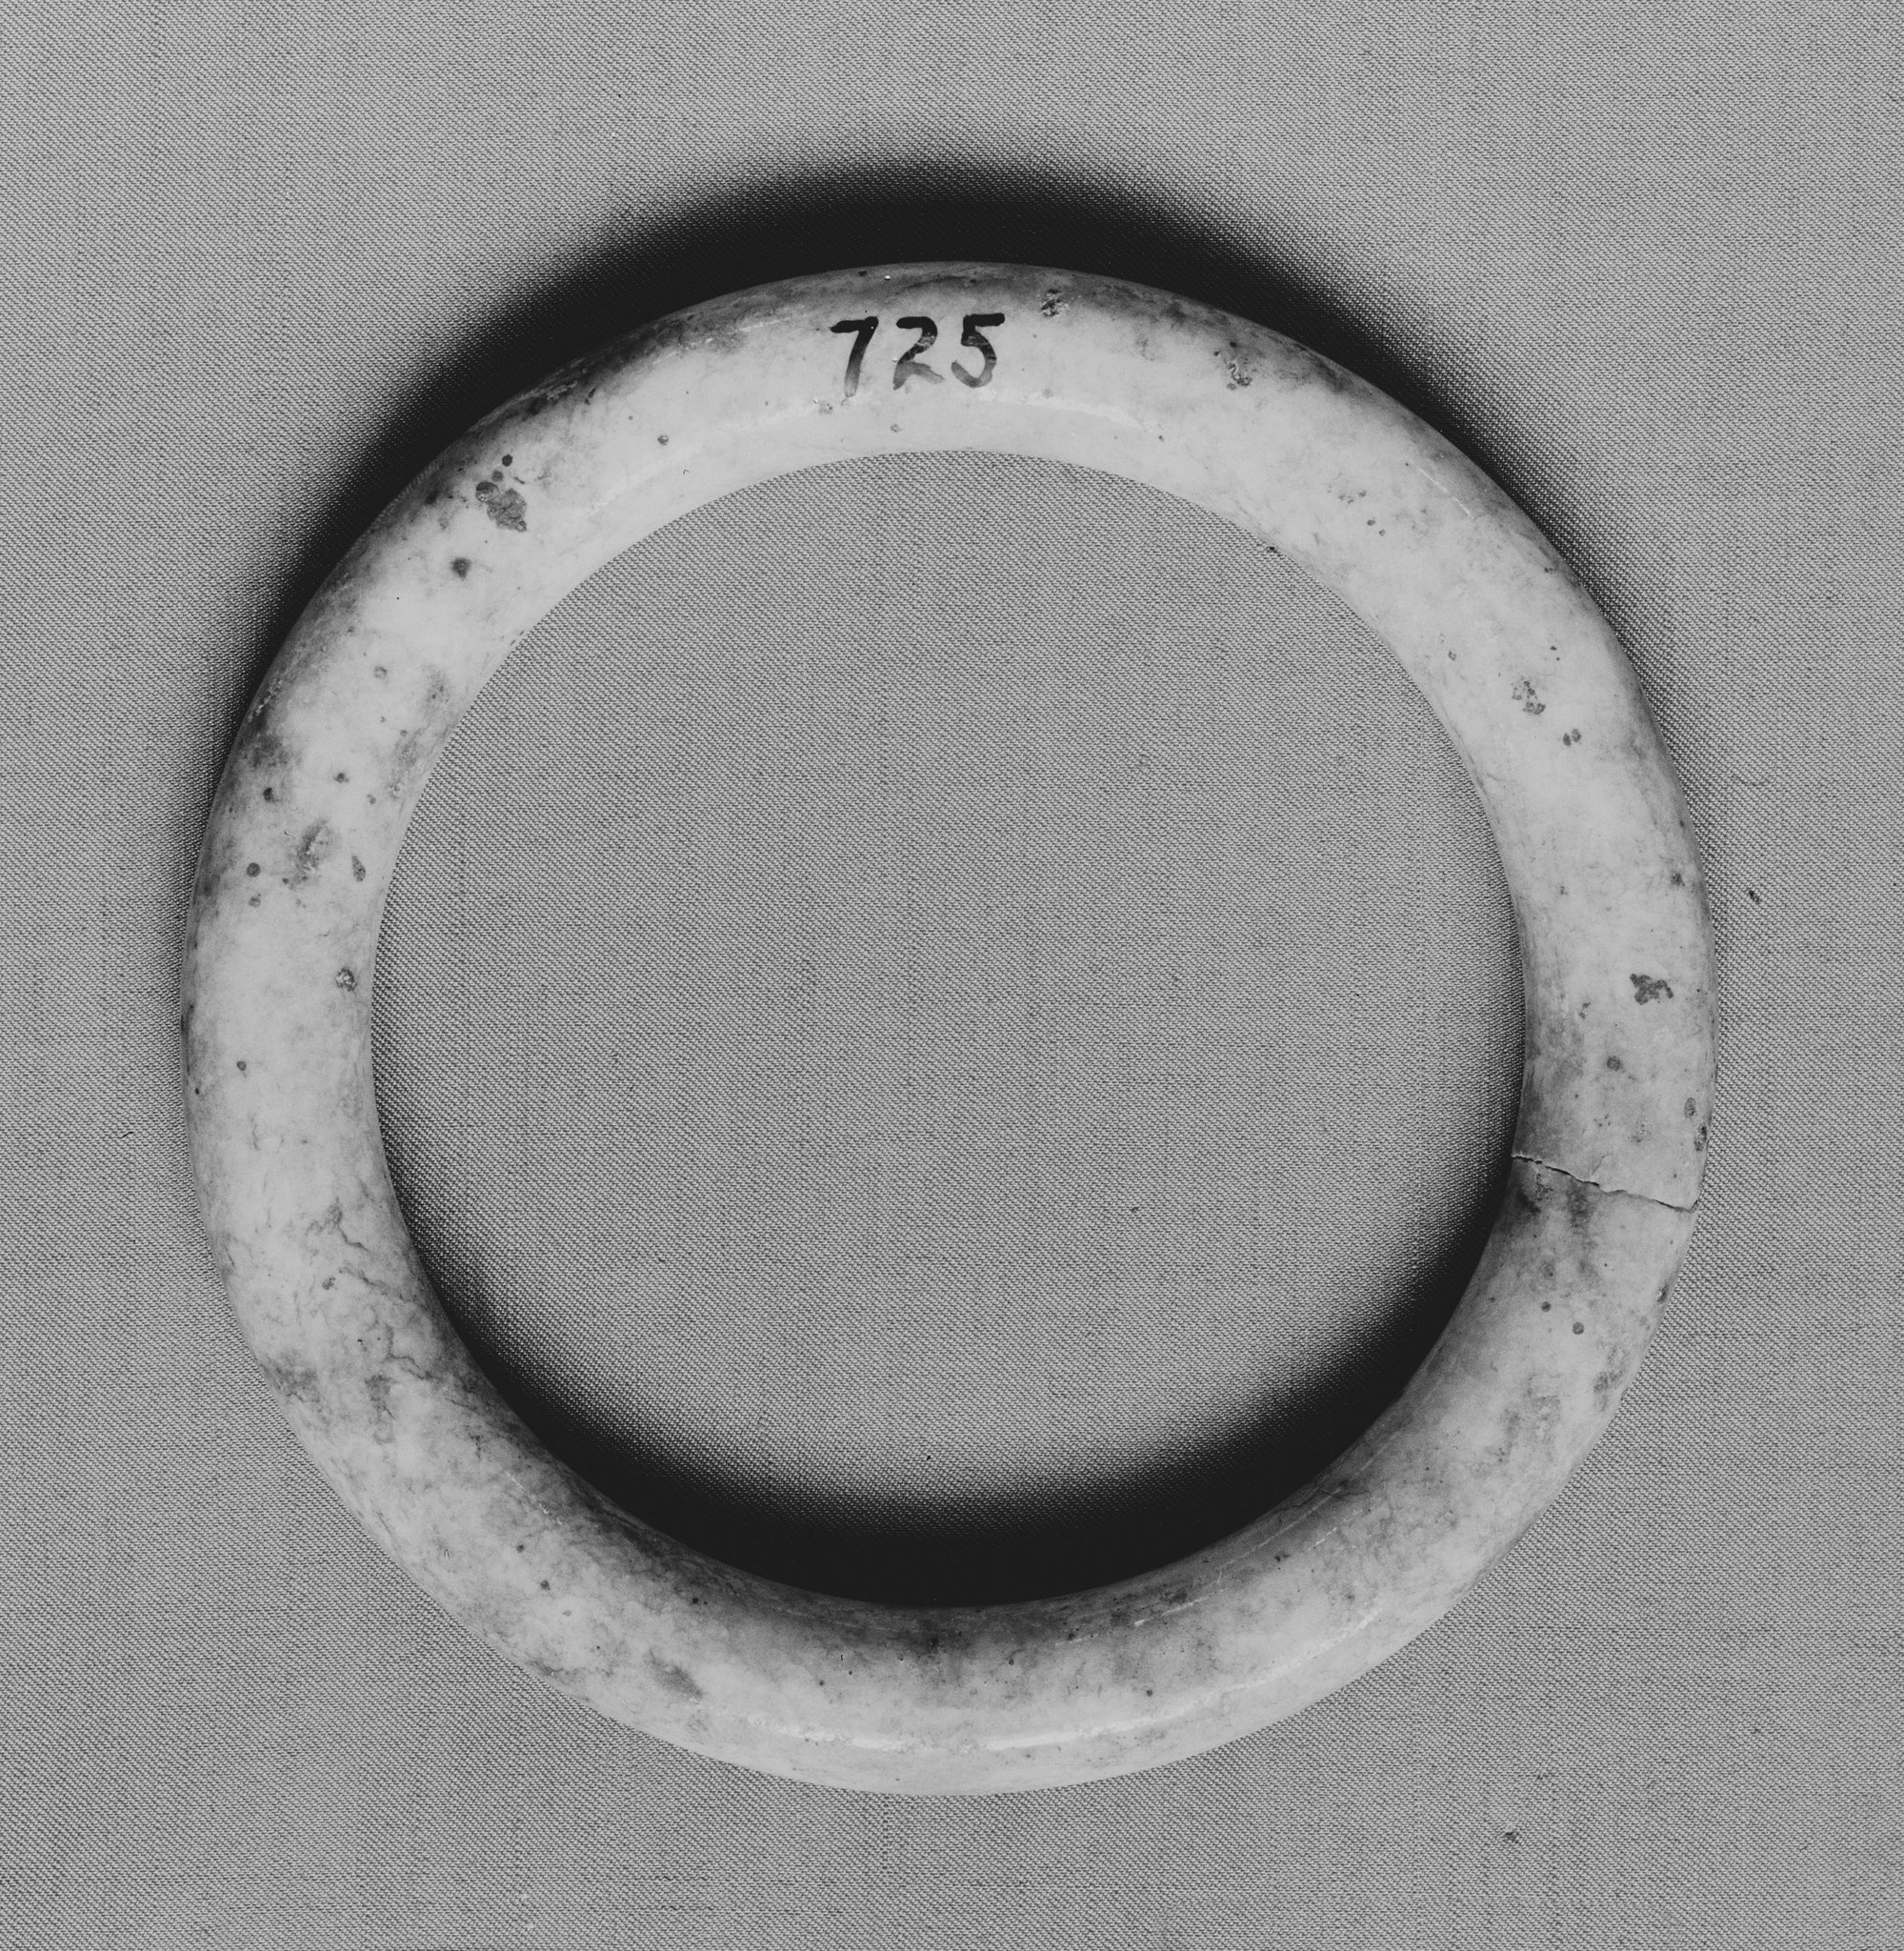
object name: farmlet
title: Armlet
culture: chinese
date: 1796-1875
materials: jade